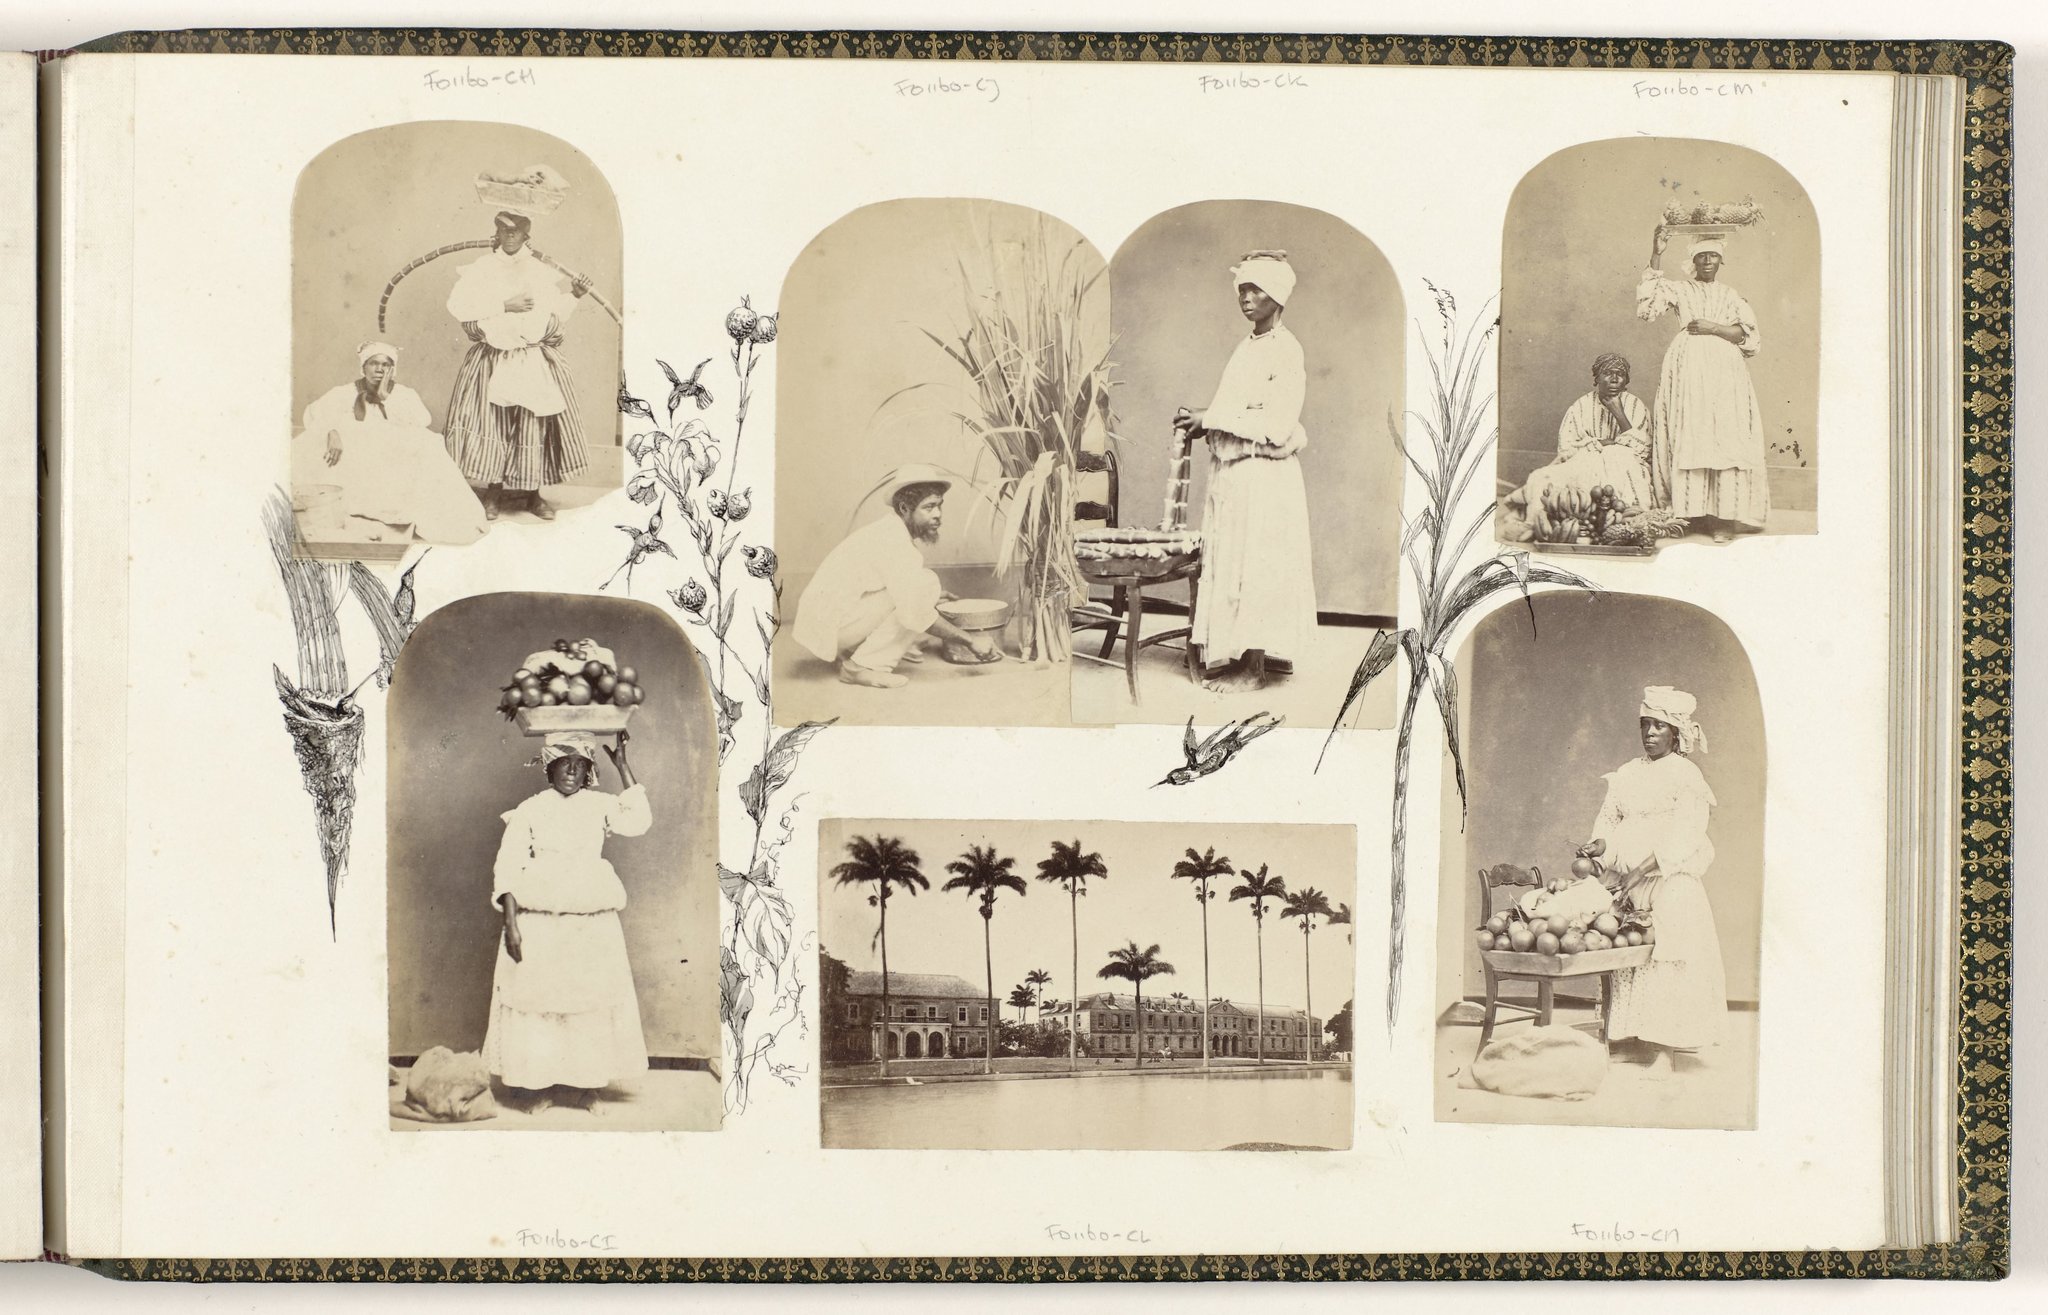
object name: album leaf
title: Portret van een onbekende knielende man met een bos bamboetakken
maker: Anonymous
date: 1870-1880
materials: paper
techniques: albumen print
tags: historical persons